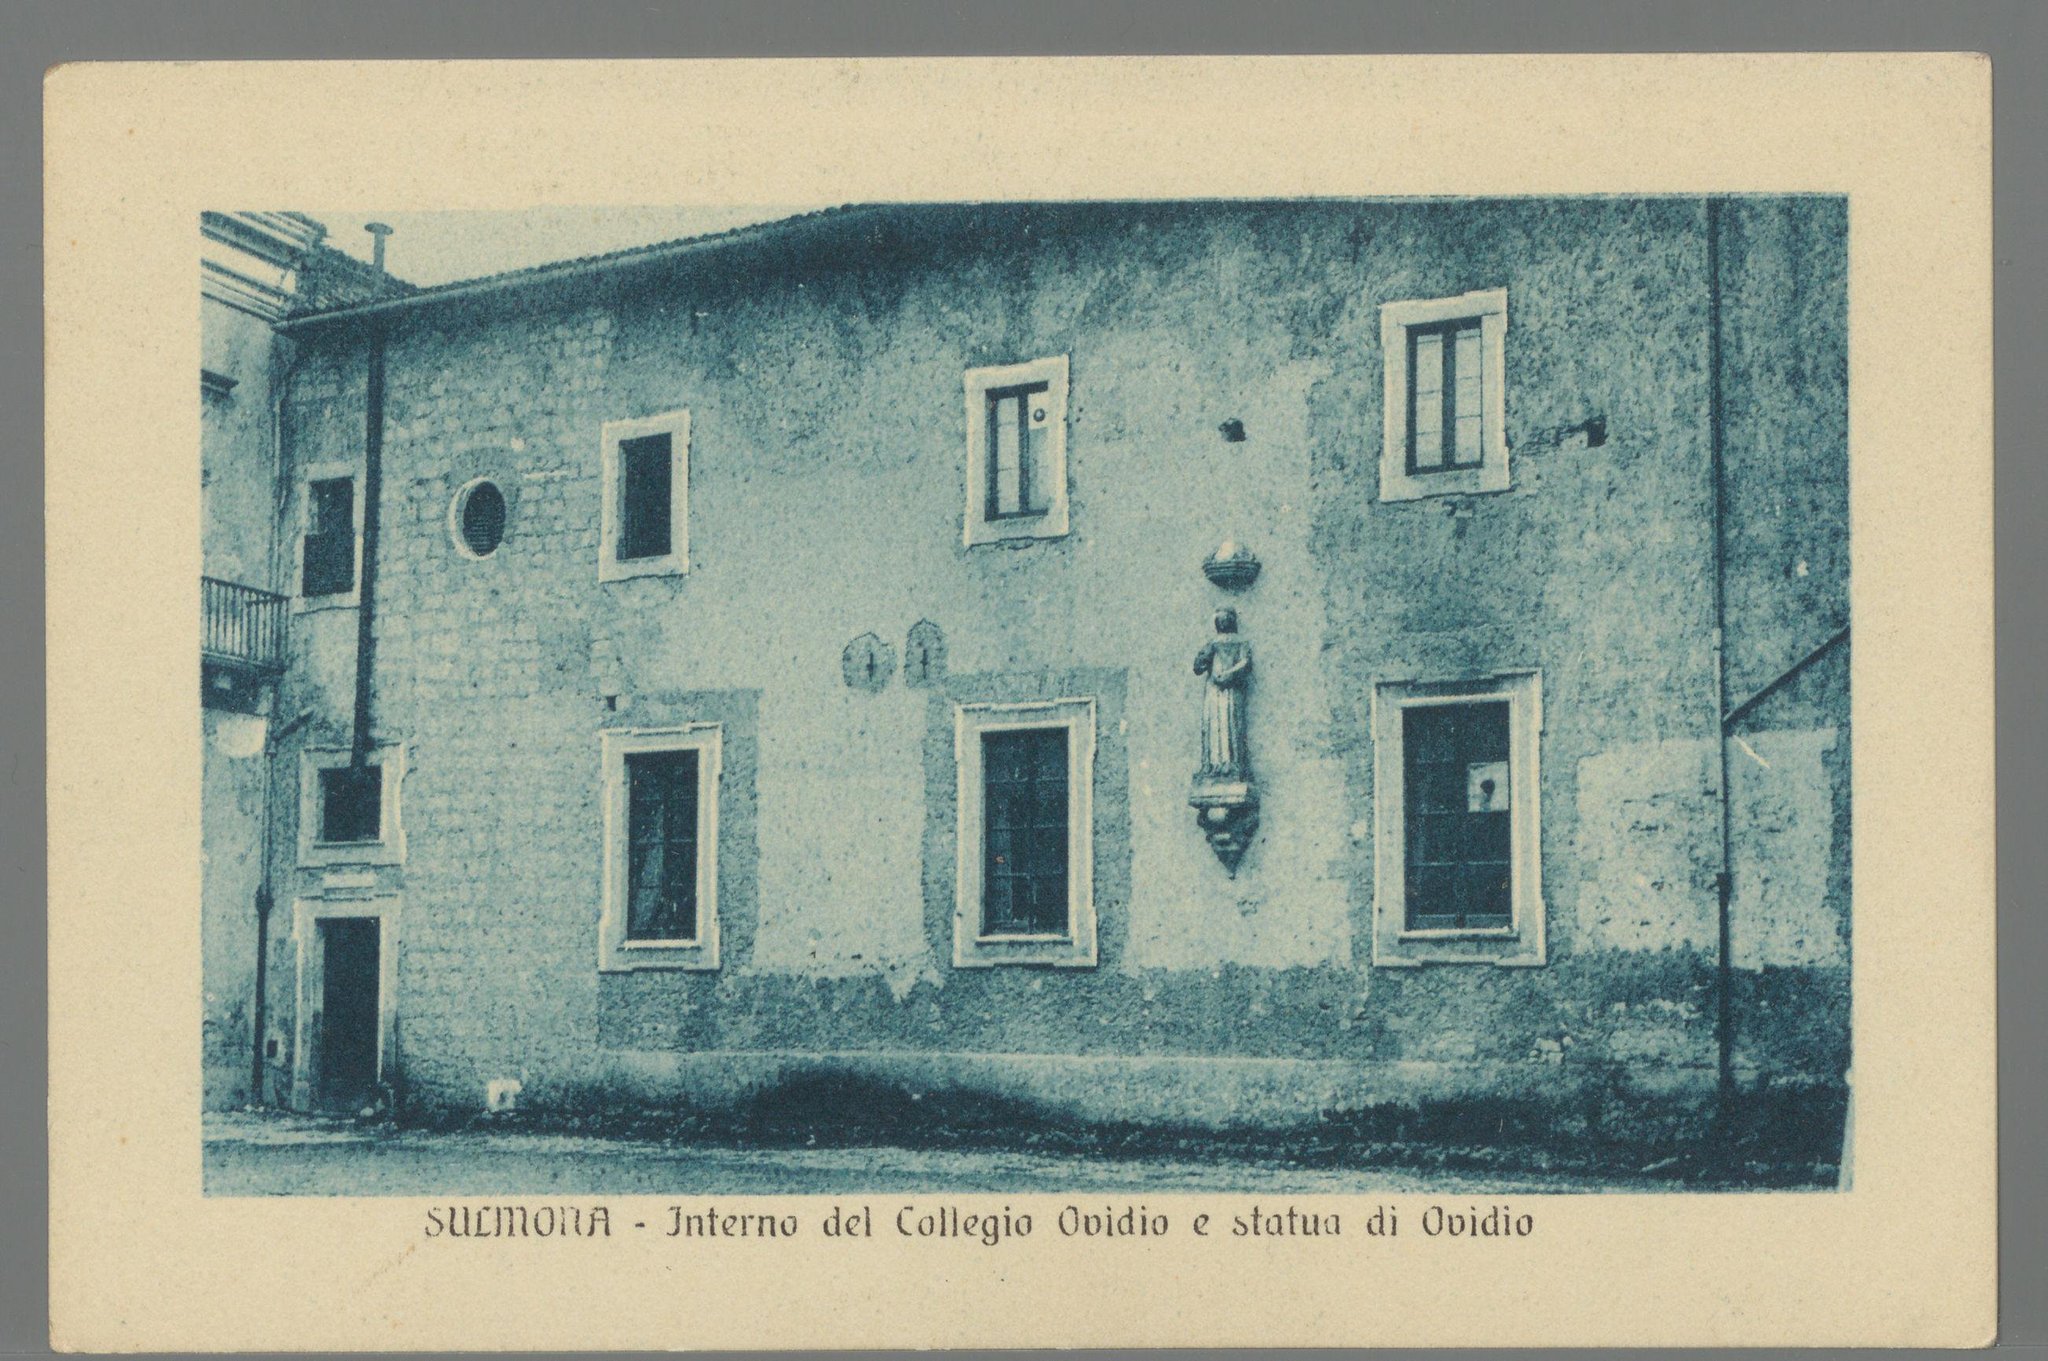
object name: photomechanical print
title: Sulmona. Interno del Collegio Ovidio e statua di Ovidio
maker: Anonymous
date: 1906-1920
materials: cardboard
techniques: photograph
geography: milan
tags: scholastic education, tuition (+ building ~ education, tuition), courtyard